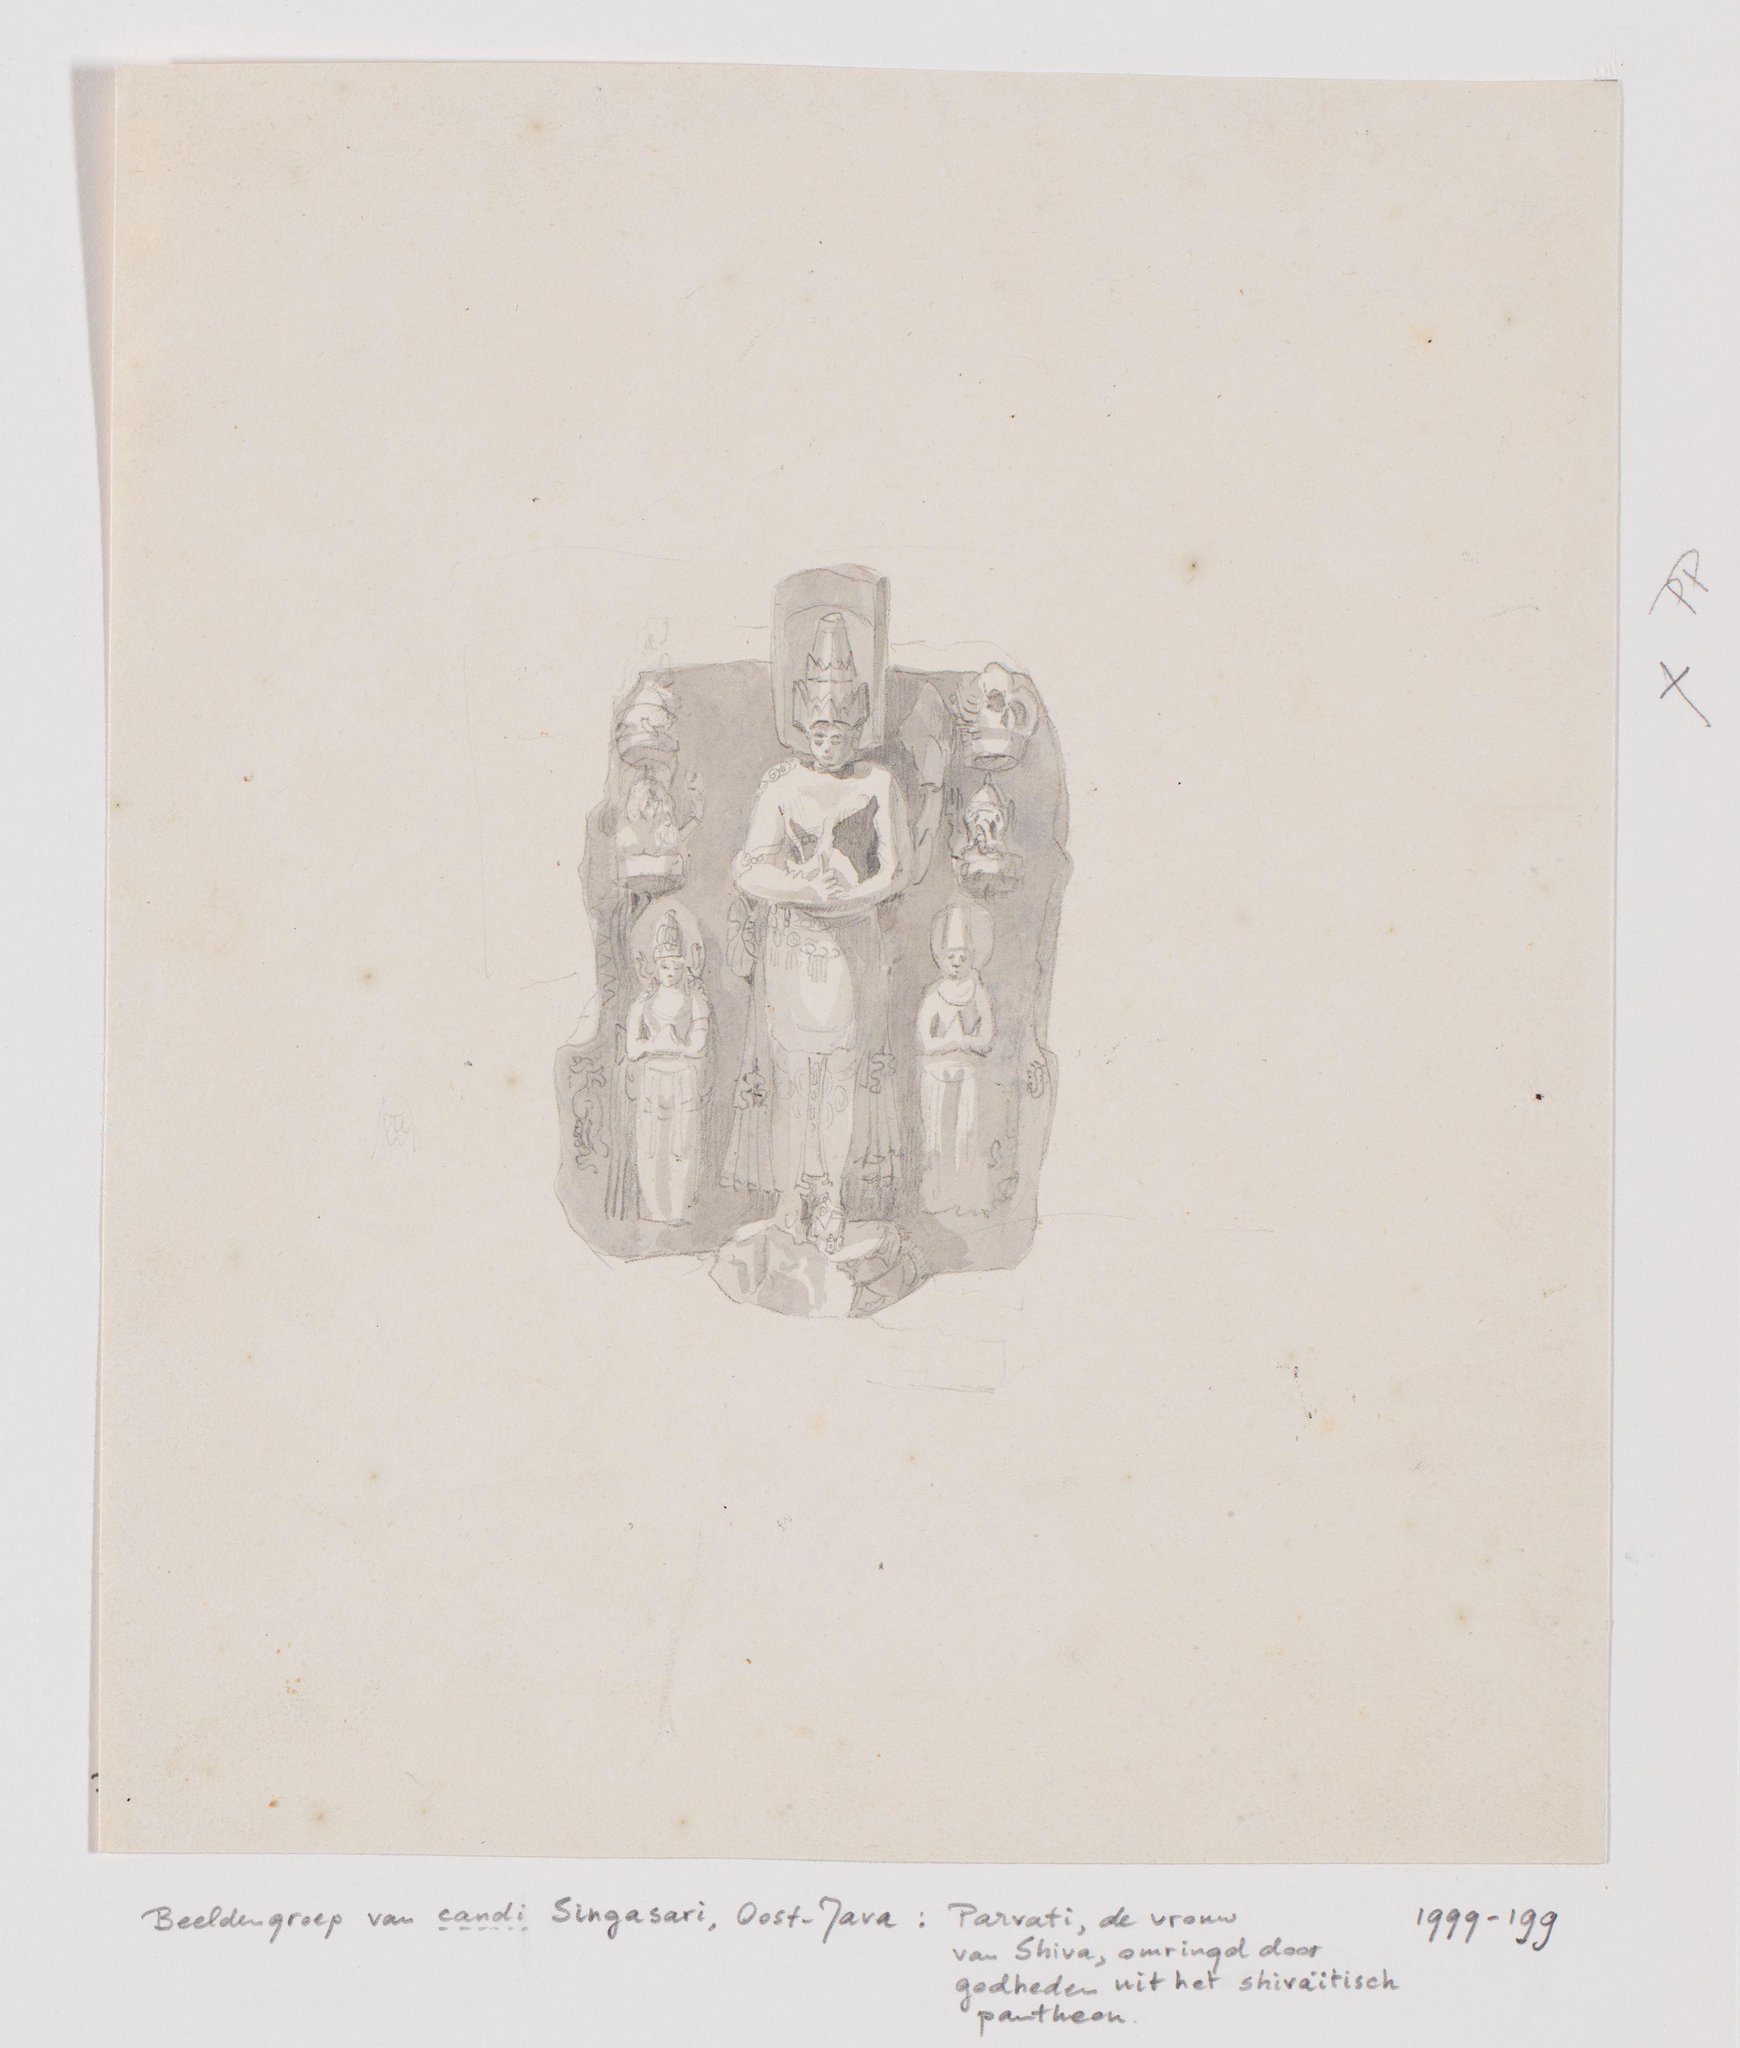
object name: drawing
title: Beeldengroep van Candi Singasari, Oost-Java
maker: adrianus johannes bik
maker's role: draughtsman, print maker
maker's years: 1790-1872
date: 1822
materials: ink, paper, pencil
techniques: brush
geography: east java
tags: shiva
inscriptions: monogram: ‘AJB’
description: Parvati, vrouwelijke verschijningsvorm van Shiva, omringd door godheden uit het shivaïtisch pantheon.